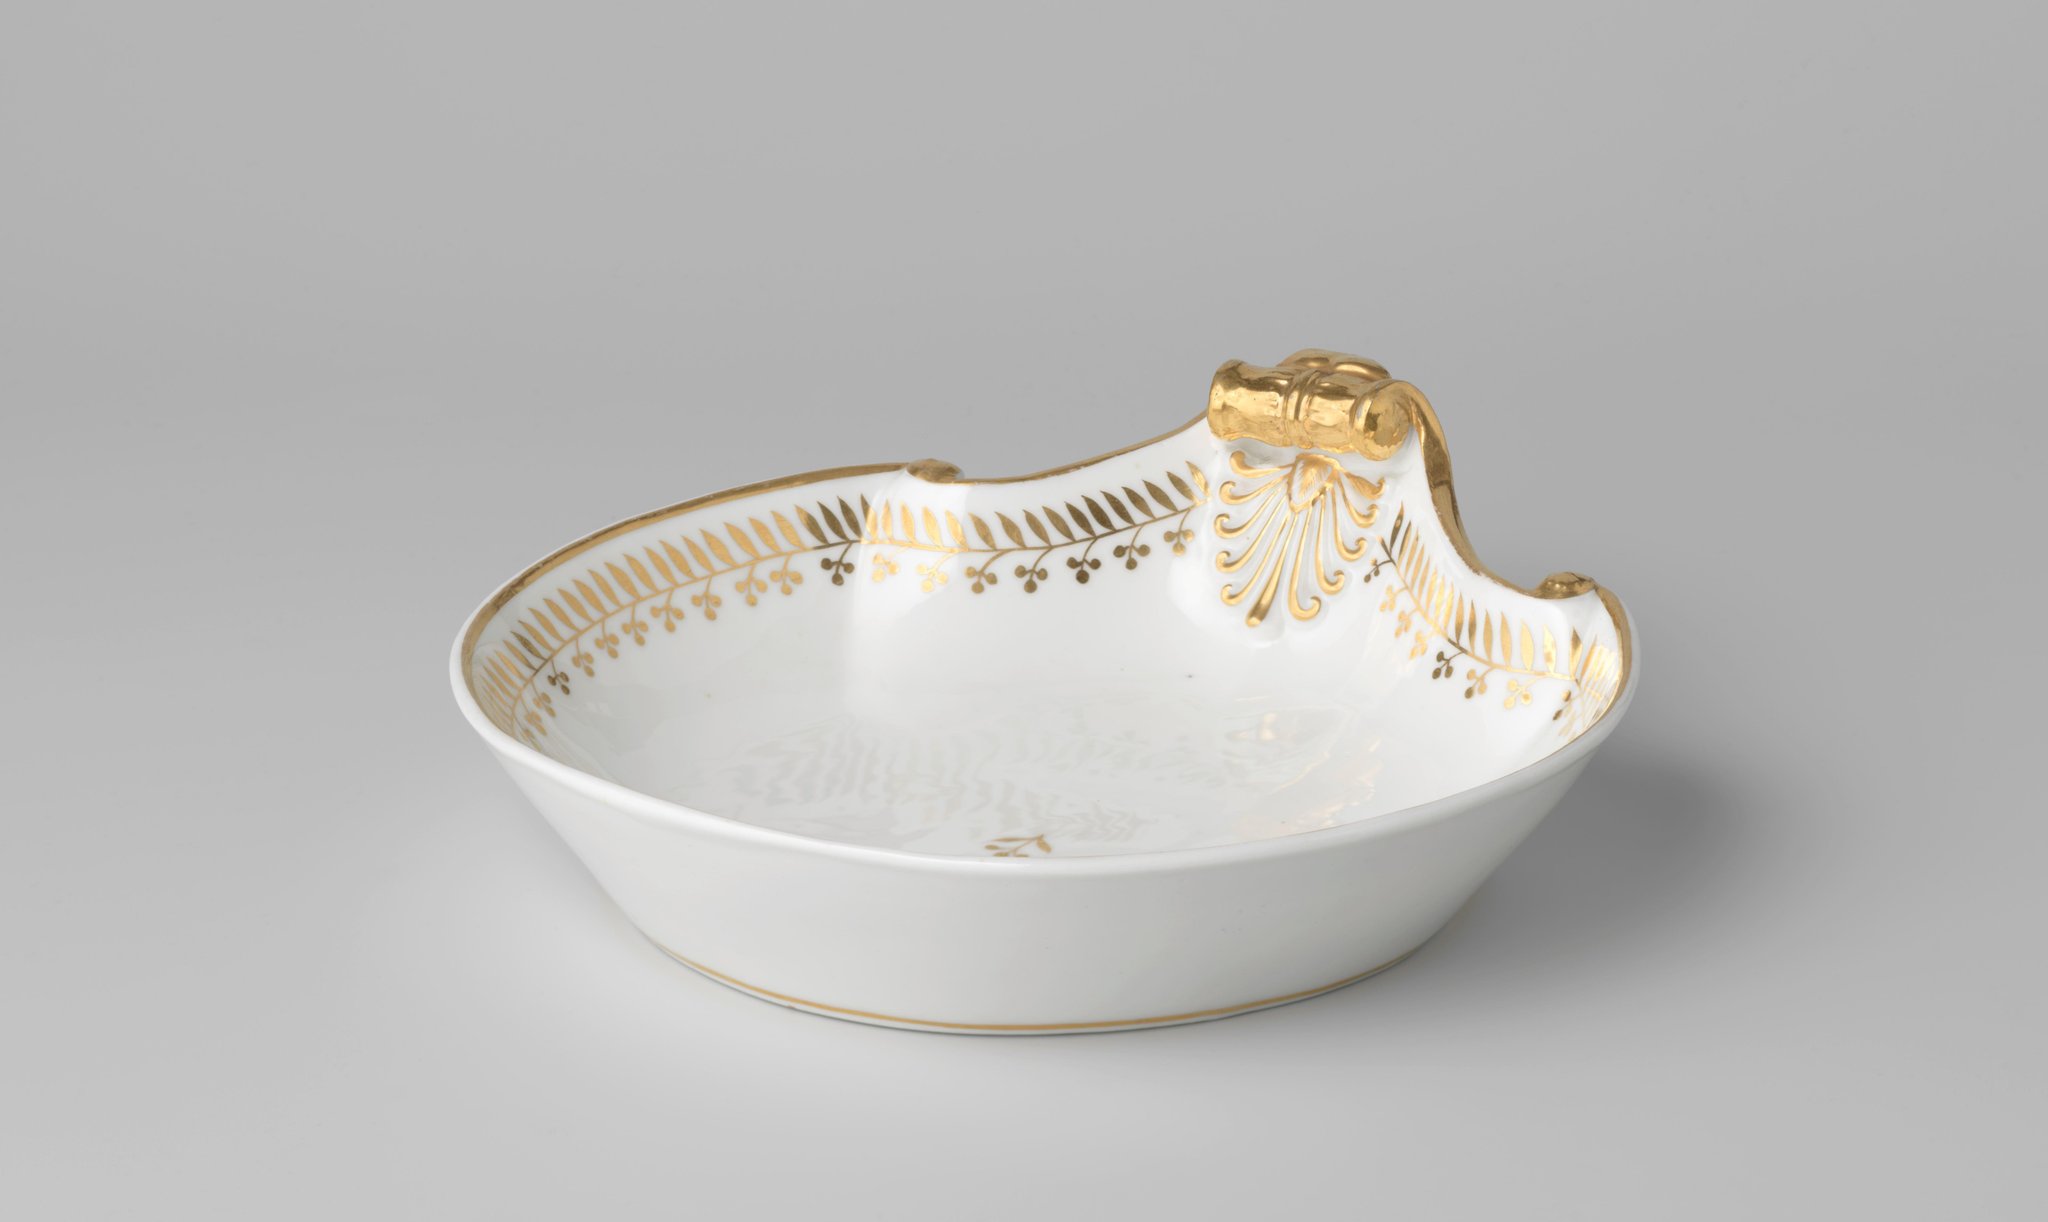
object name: service set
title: Dish with handle and stylized floral scrolls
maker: Anonymous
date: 1800-1810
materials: glaze, gold, paint, porcelain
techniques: firing, forming, gilding, vitrification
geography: france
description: Schaal van porselein, rond model met een als handvat dienende uitschulping. De uitschulping wordt gevormd door een vergulde voluut waaronder een palmet met aan weerszijden S-voluten. De schaal is langs de rand versierd met een gouden bies en met een doorlopende tak met bladeren en bloemen.